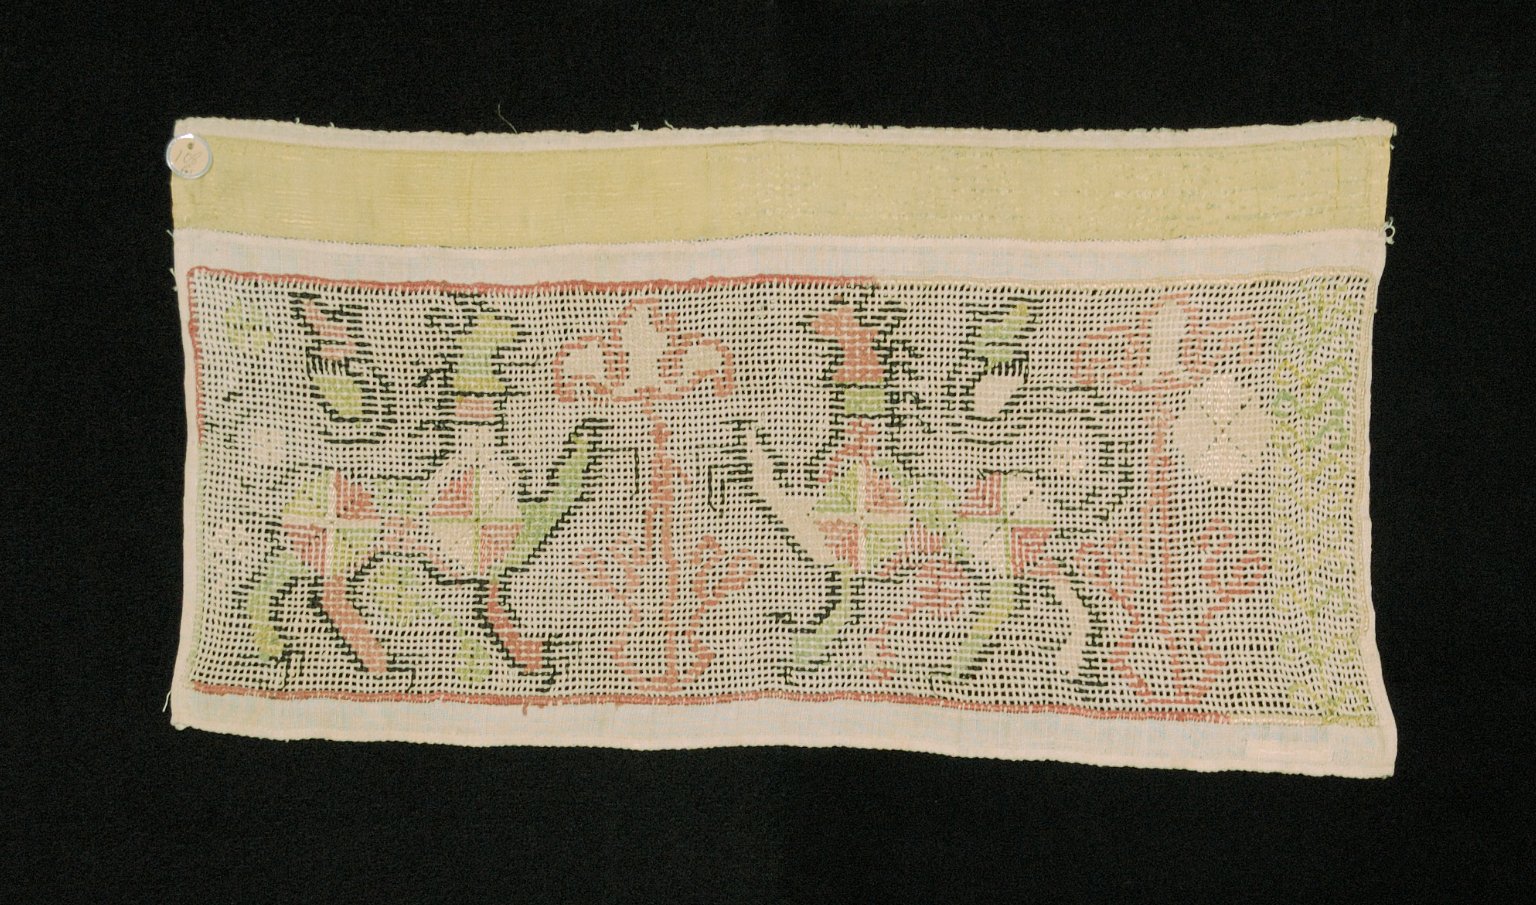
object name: border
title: Towel border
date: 1800-1850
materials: linen, silk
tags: animals